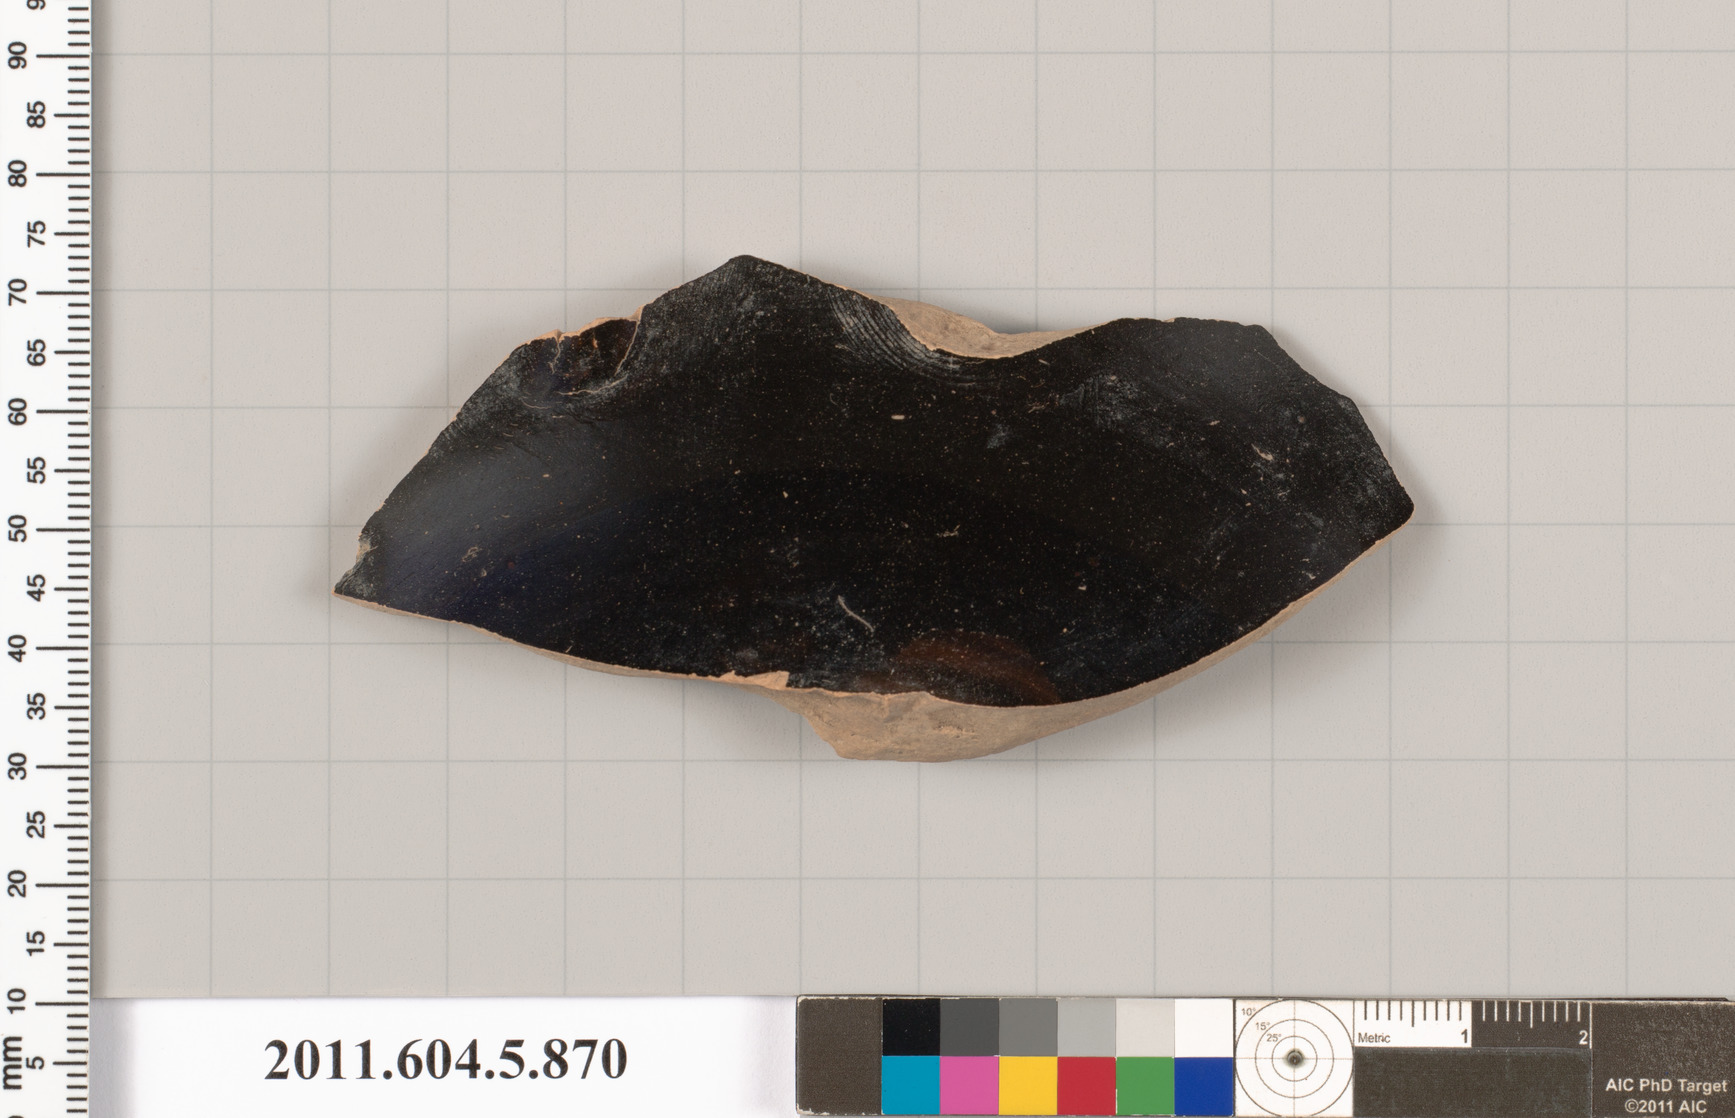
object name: kylix fragment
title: Terracotta fragment of a kylix (drinking cup)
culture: greek, attic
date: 600-401 BCE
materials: terracotta